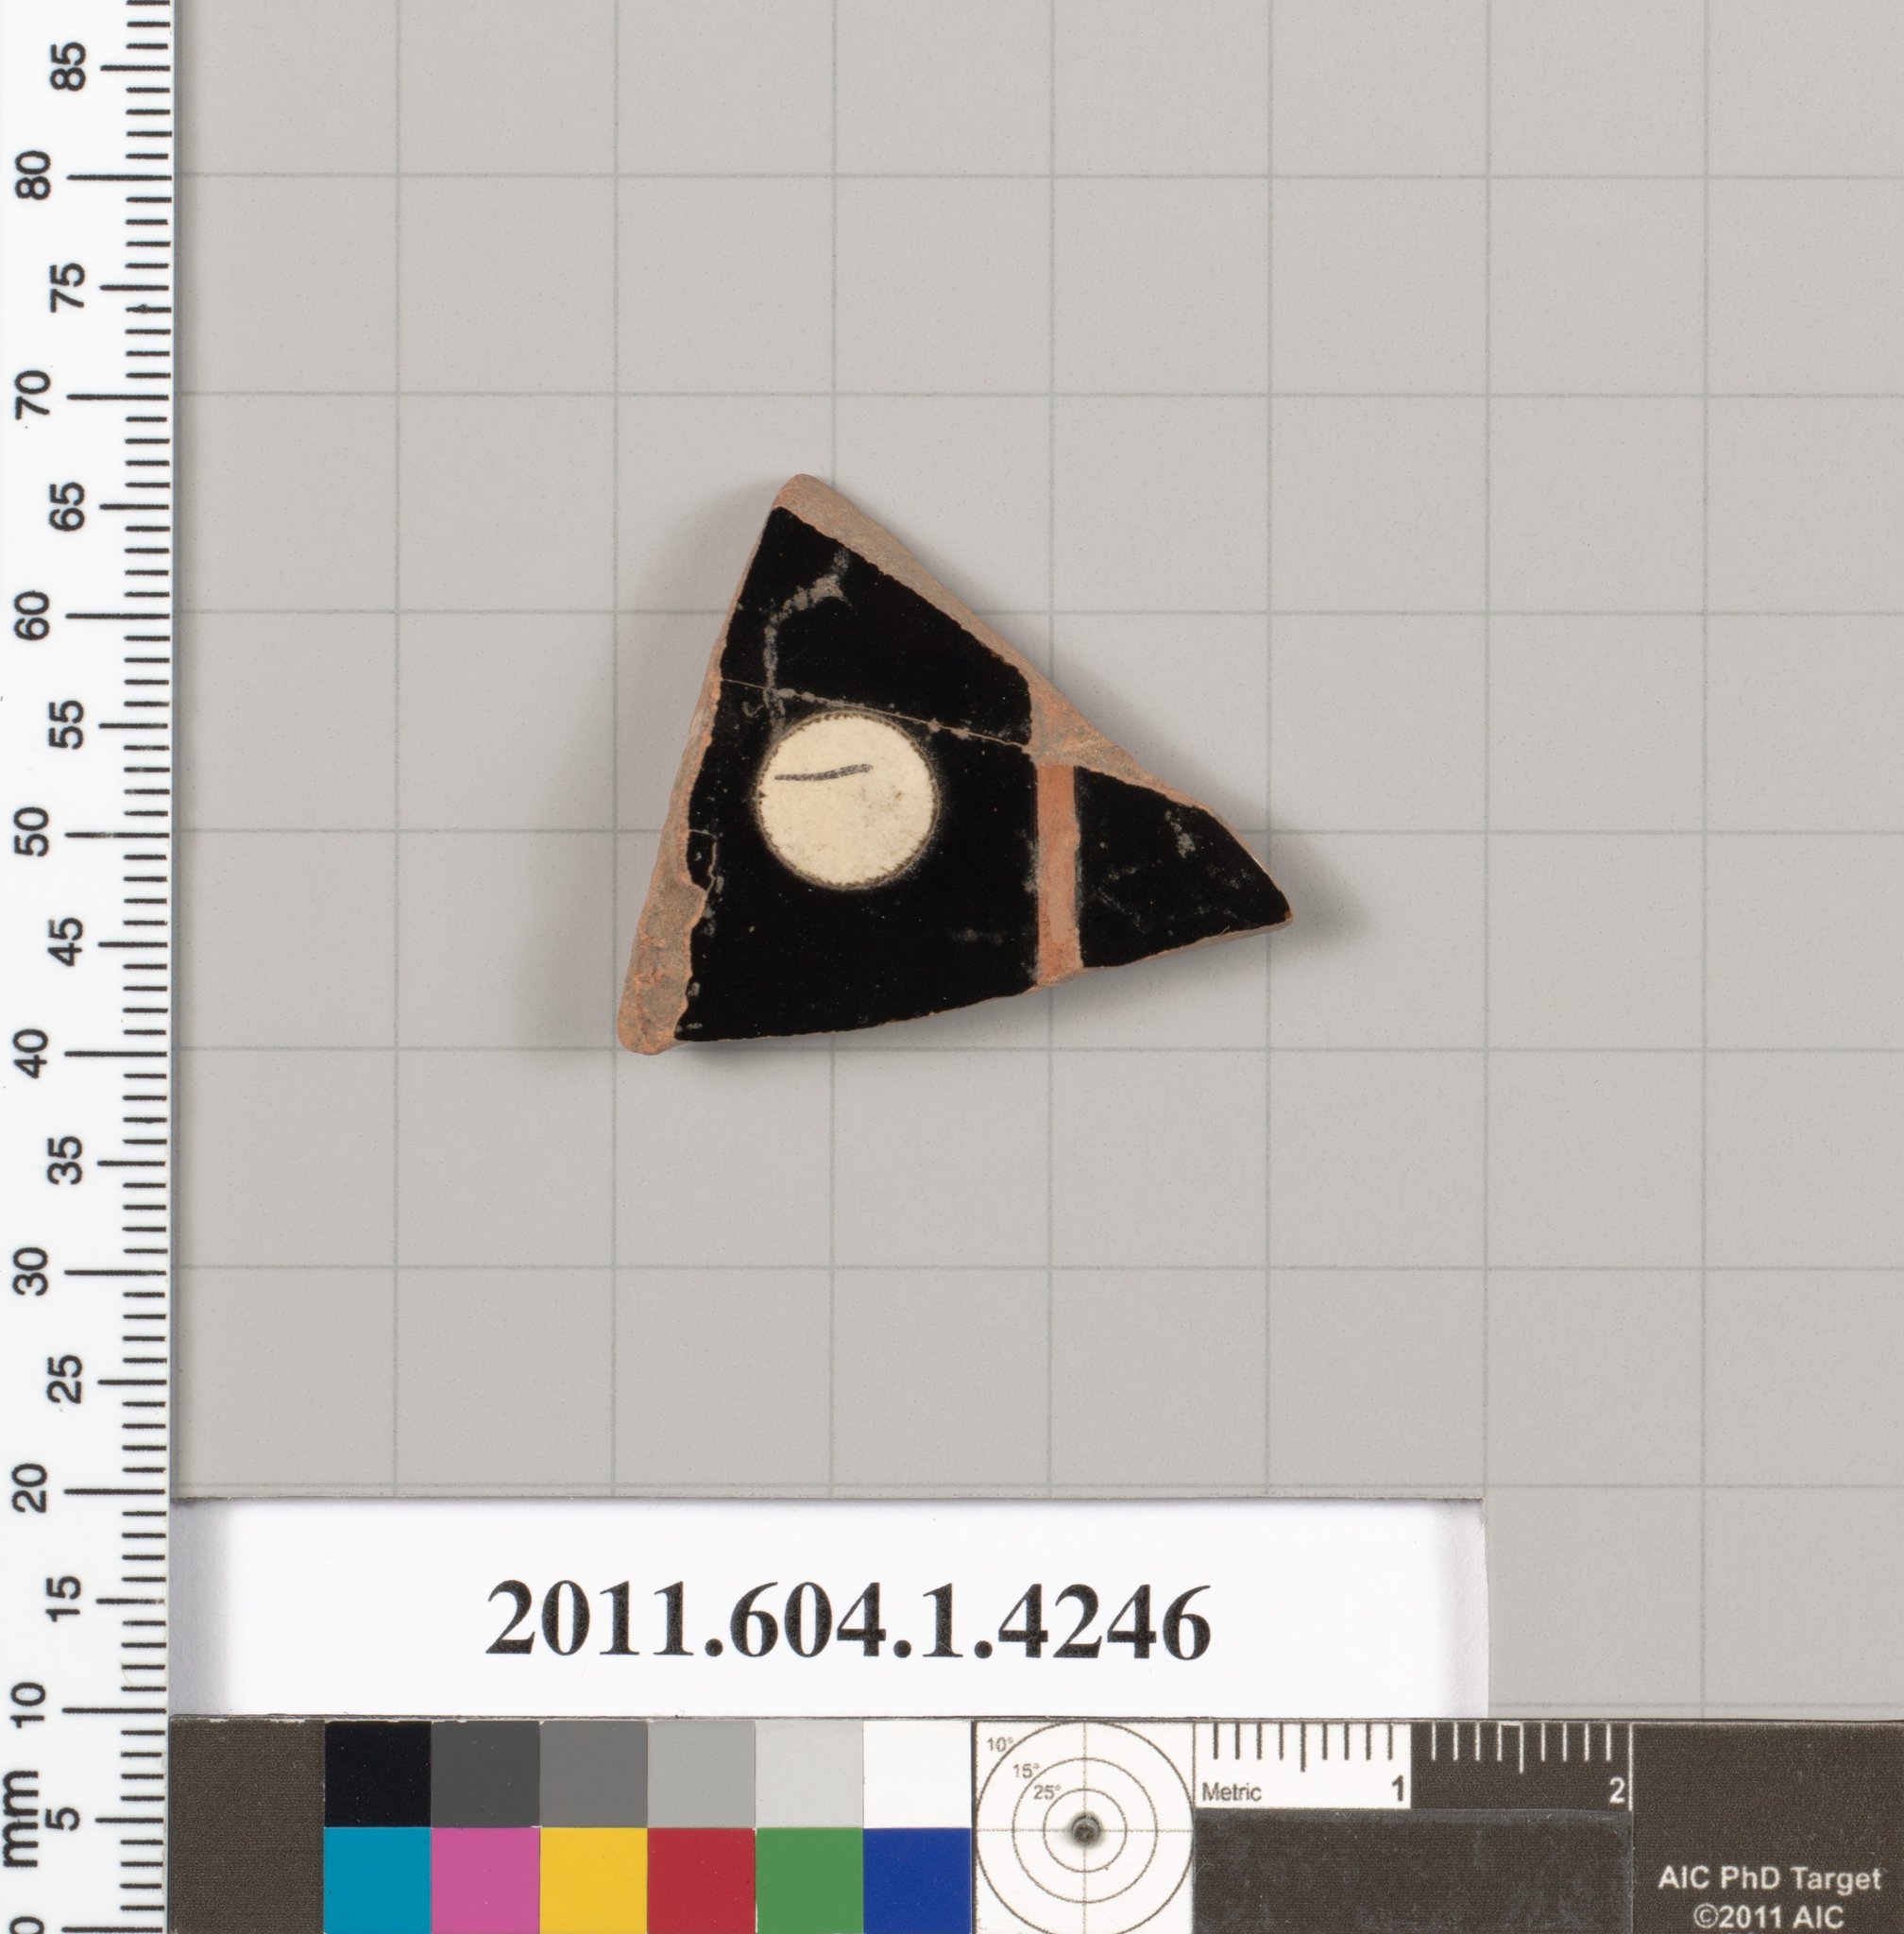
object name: kylix fragment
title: Terracotta fragment of a kylix (drinking cup)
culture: greek, attic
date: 500-451 BCE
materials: terracotta